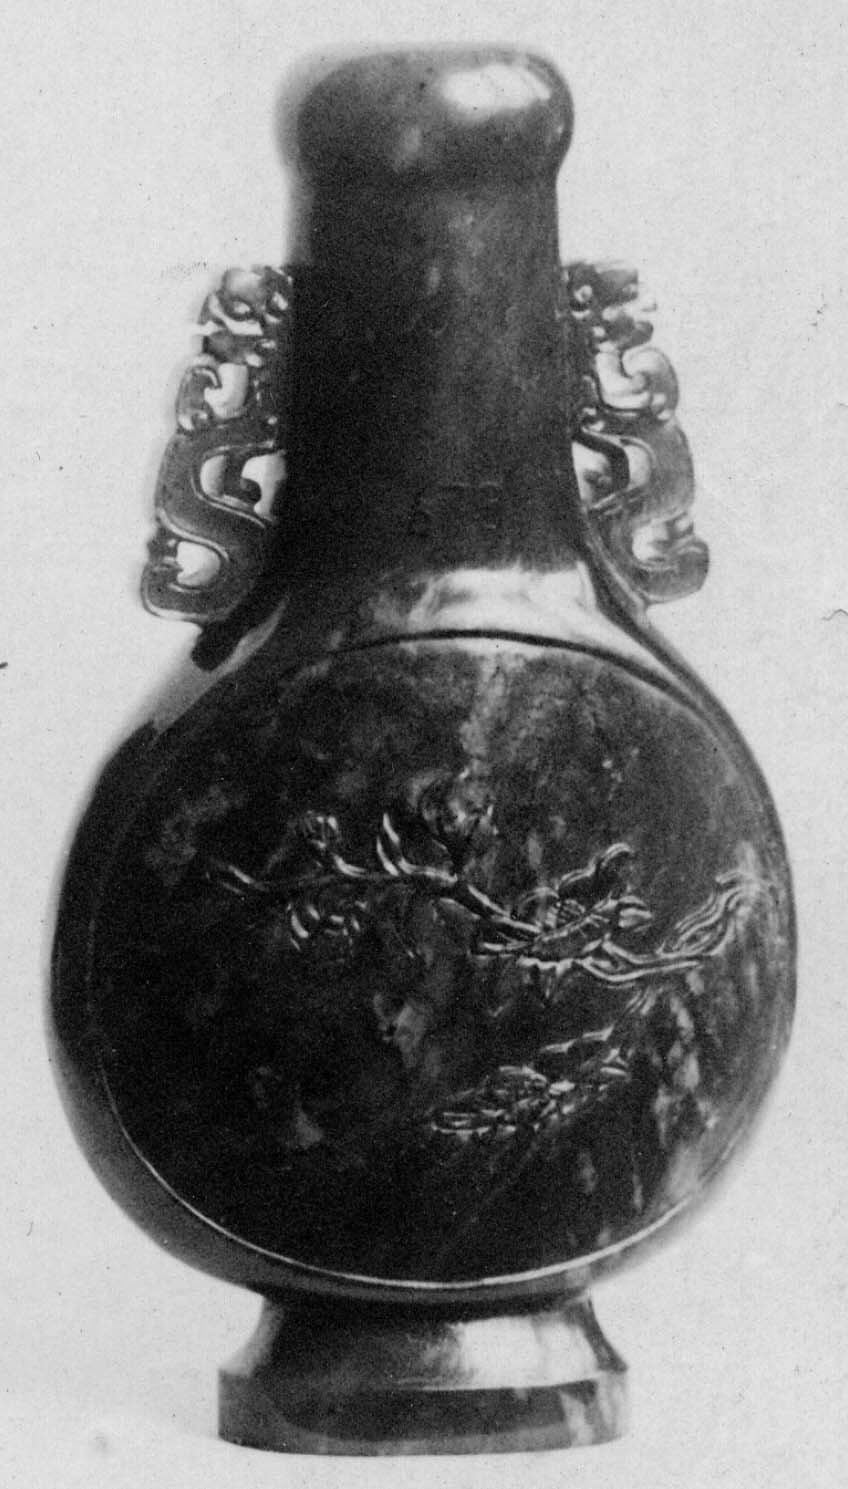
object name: vase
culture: chinese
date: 1736-1795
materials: jade